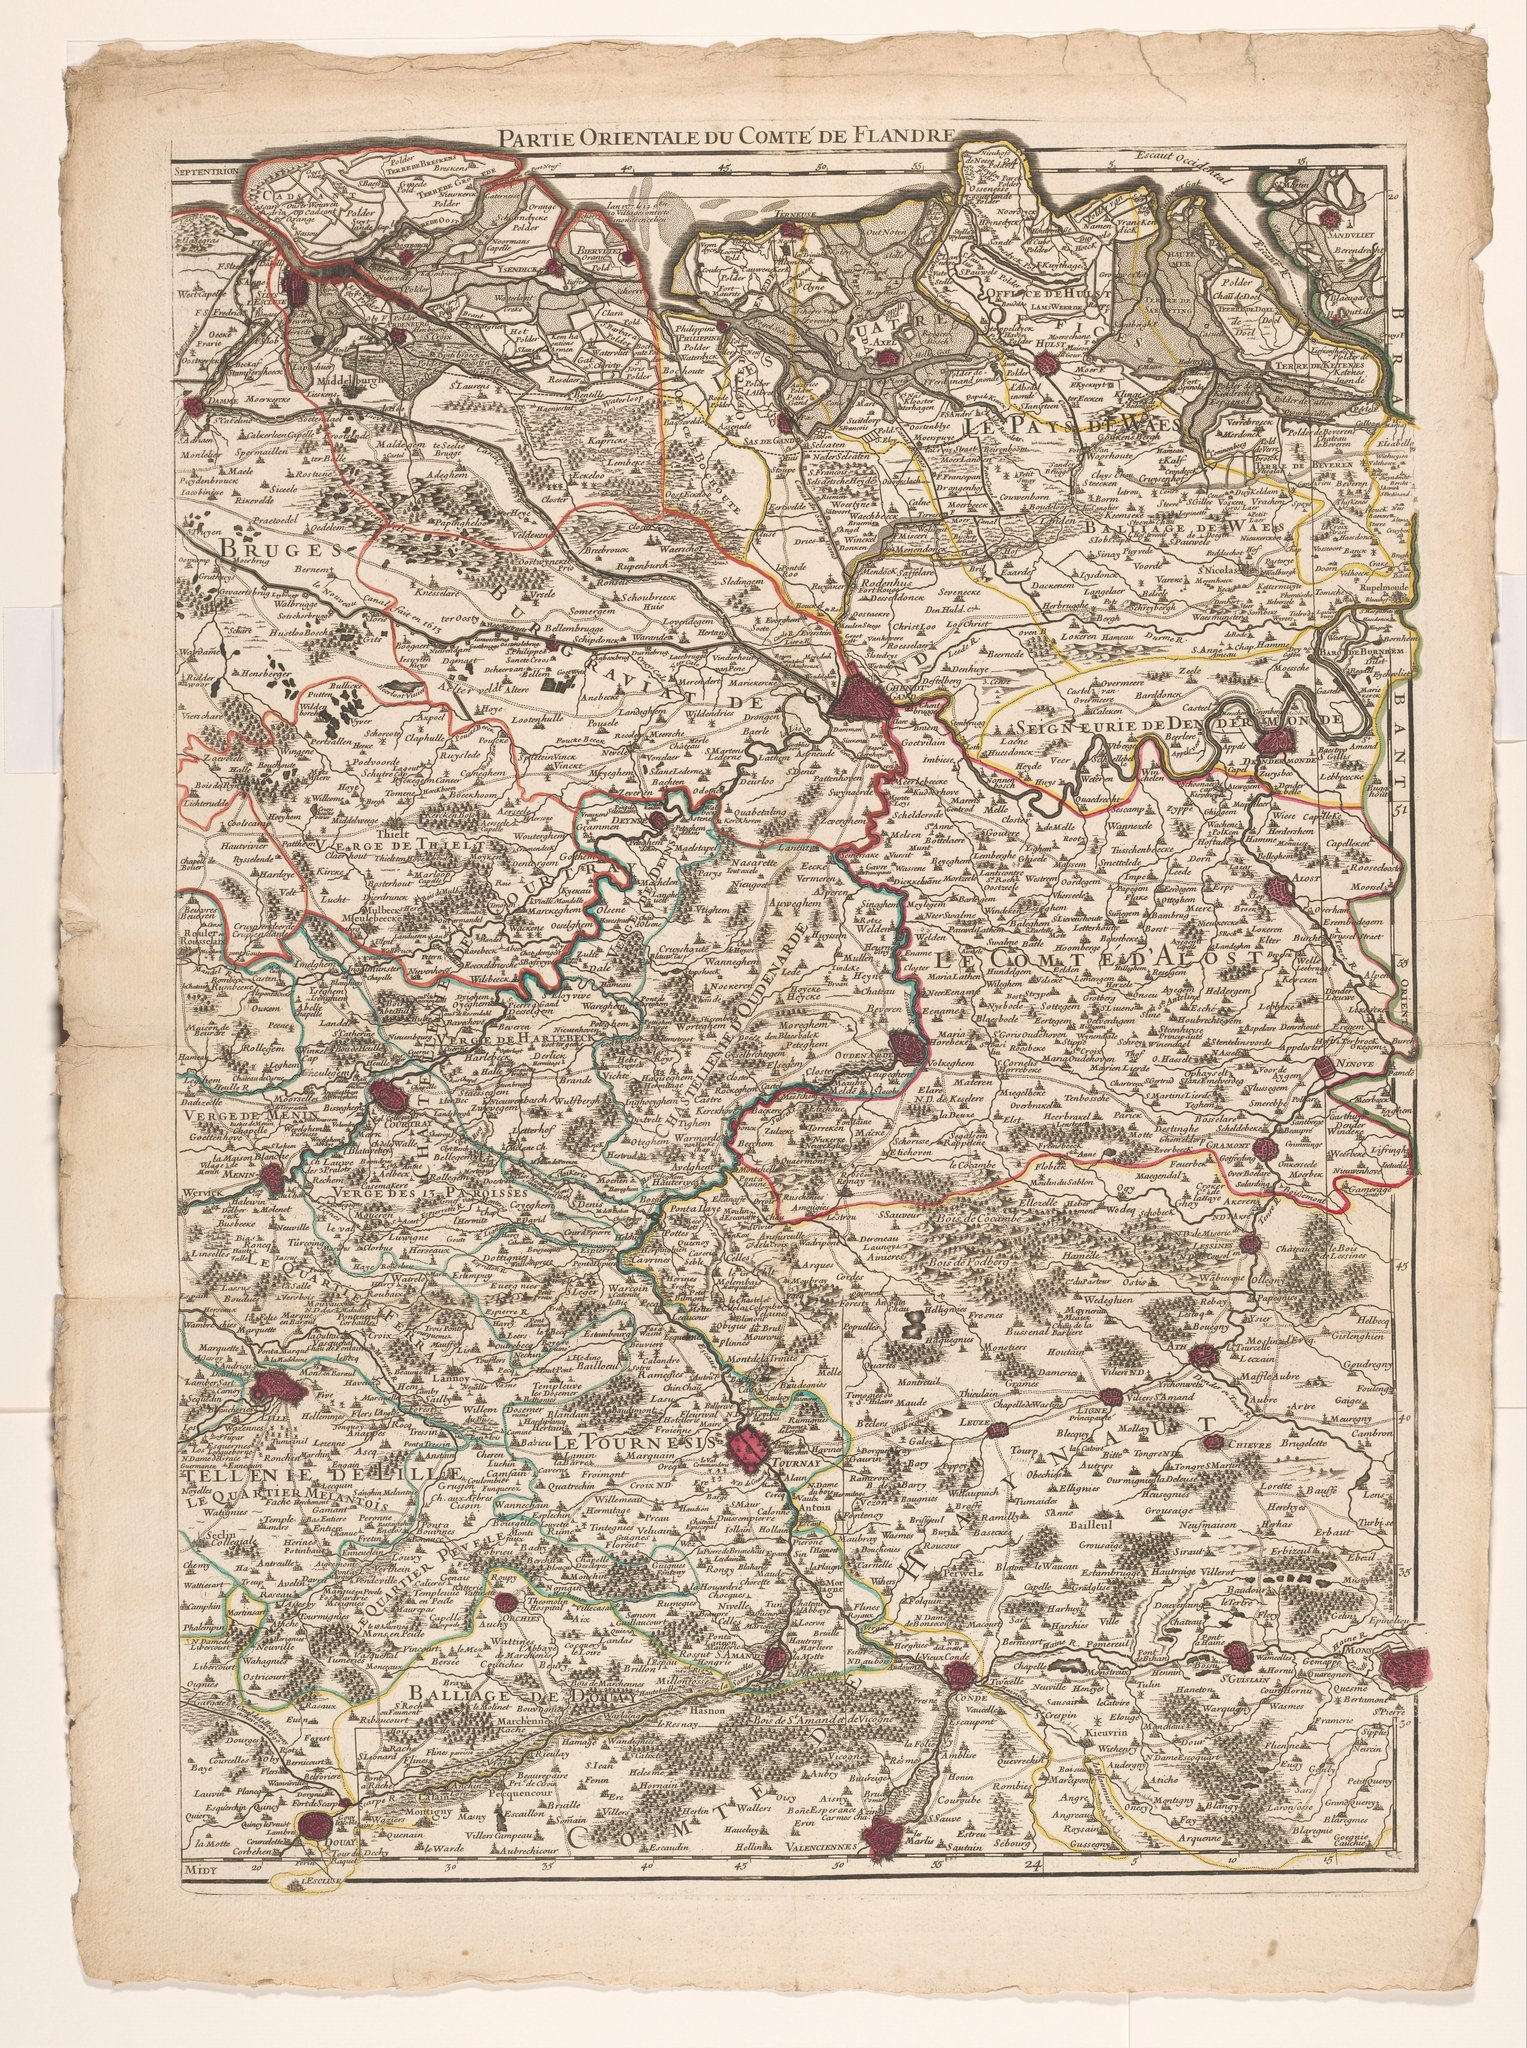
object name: map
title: Partie orientale du comté de Flandre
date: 1729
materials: paper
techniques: engraving, etching, hand coloring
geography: paris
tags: maps of separate countries or regions, armorial bearing, heraldry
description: Rechterdeel van een kaart van het graafschap Vlaanderen. Boven de kaart een titel. De kaart is voorzien van een gradenverdeling langs de randen.